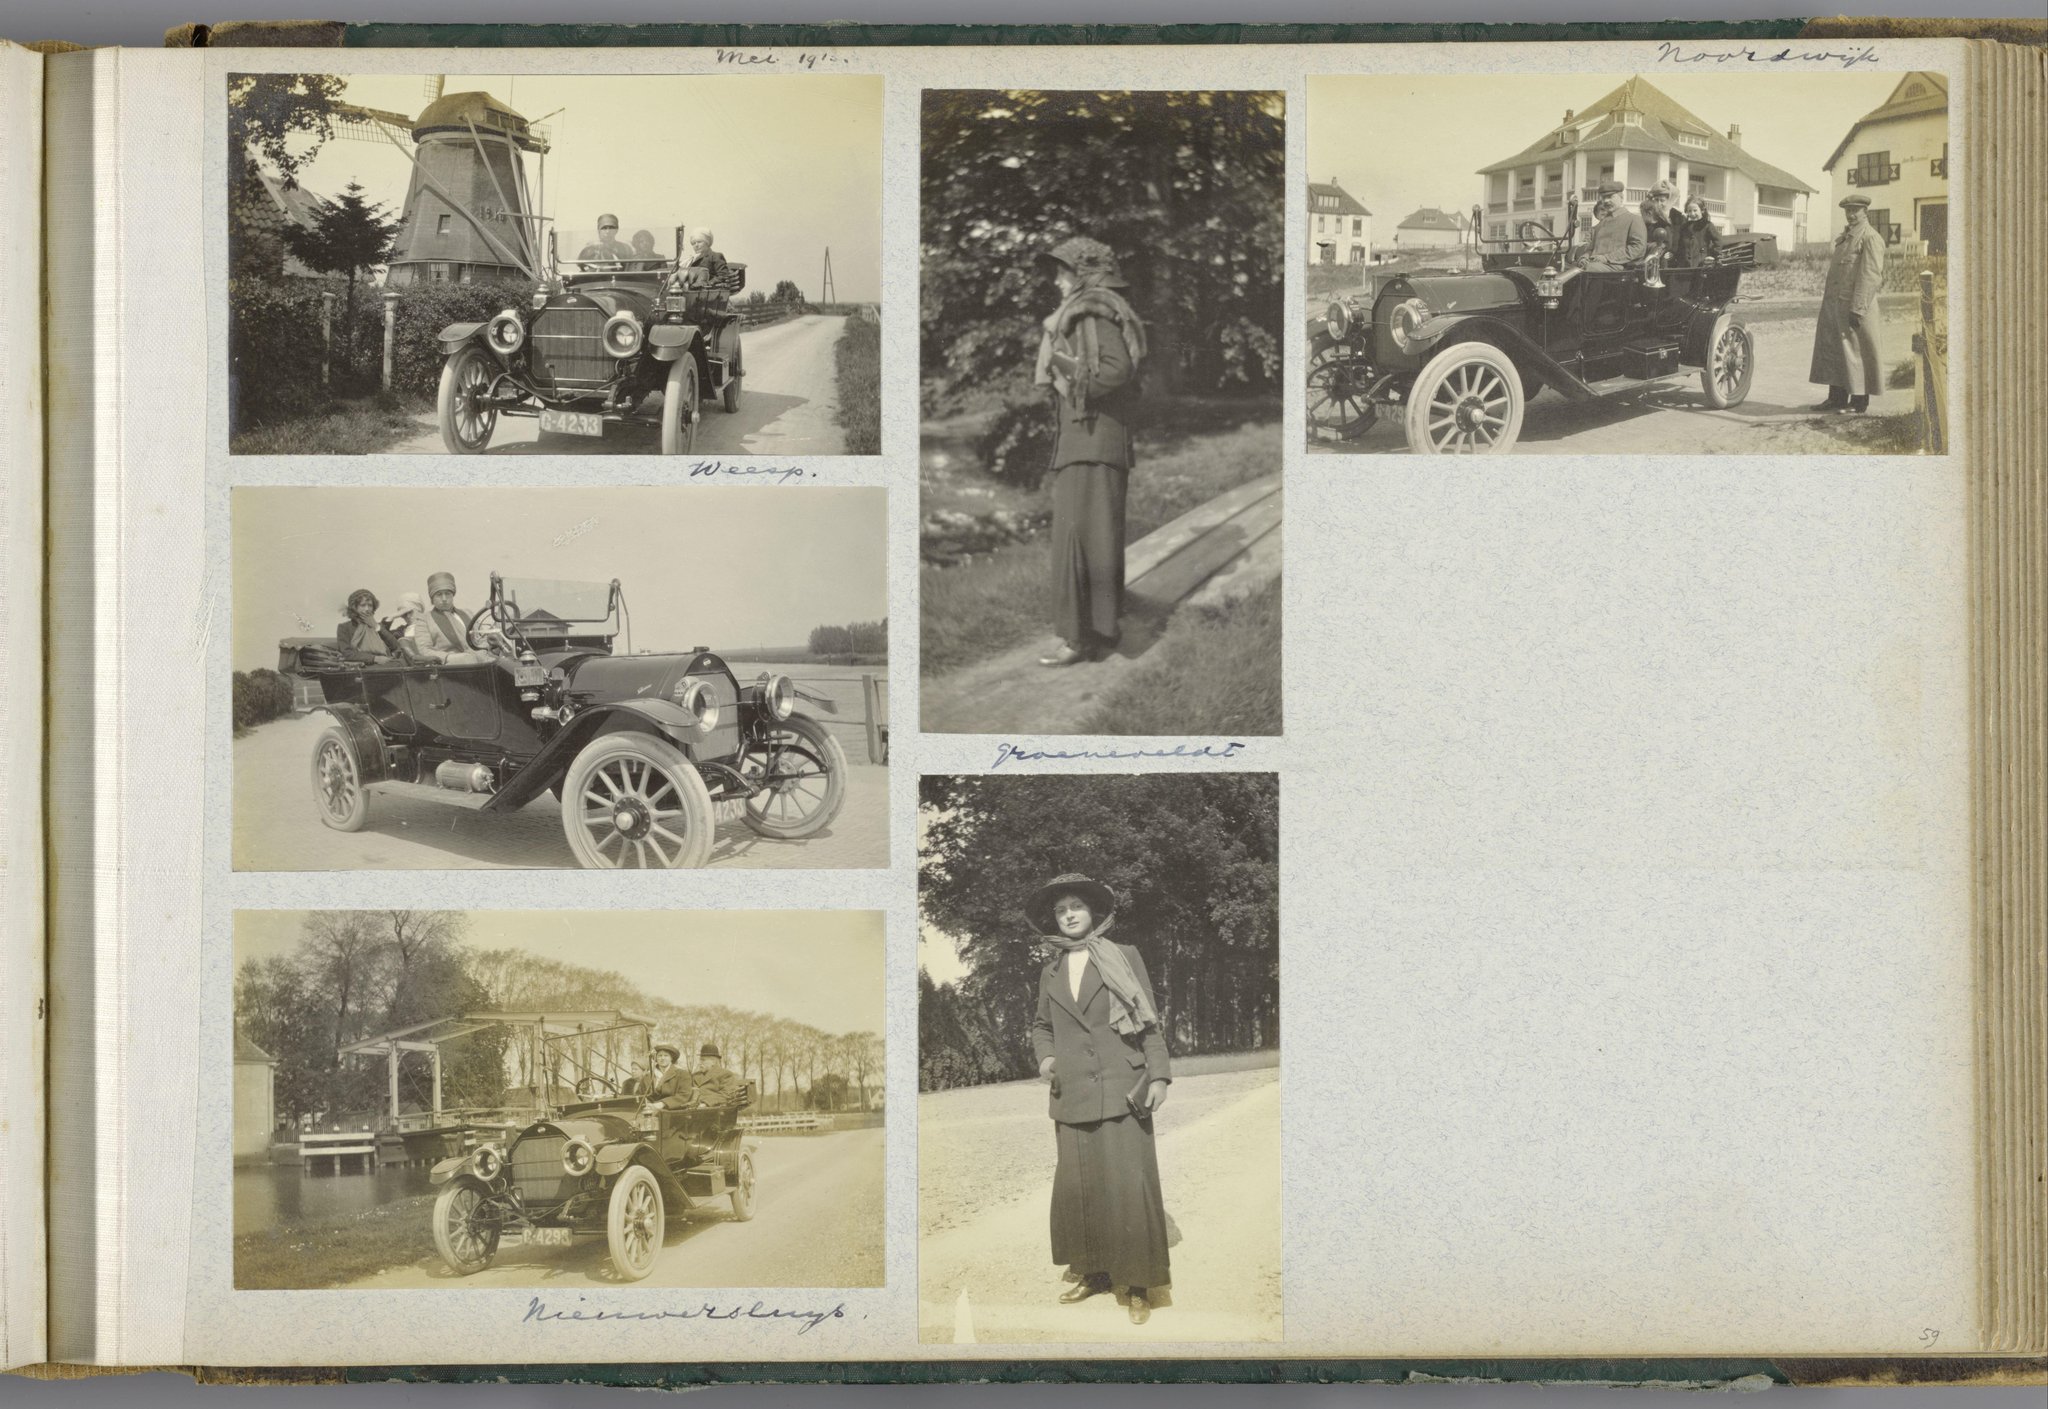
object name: photograph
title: Albumblad met zes foto's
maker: andries augustus boom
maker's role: amateurfotograaf, handelaar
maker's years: 1878-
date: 1905-1913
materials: paper, photographic support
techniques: photography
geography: netherlands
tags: andries augustus boom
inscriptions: date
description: Albumblad met zes foto's in Nederland, o.a. Weesp en Noordwijk, mei 1913. Onderdeel van het fotoalbum van de familie Boom-Gonggrijp in Suriname en Curaçao.